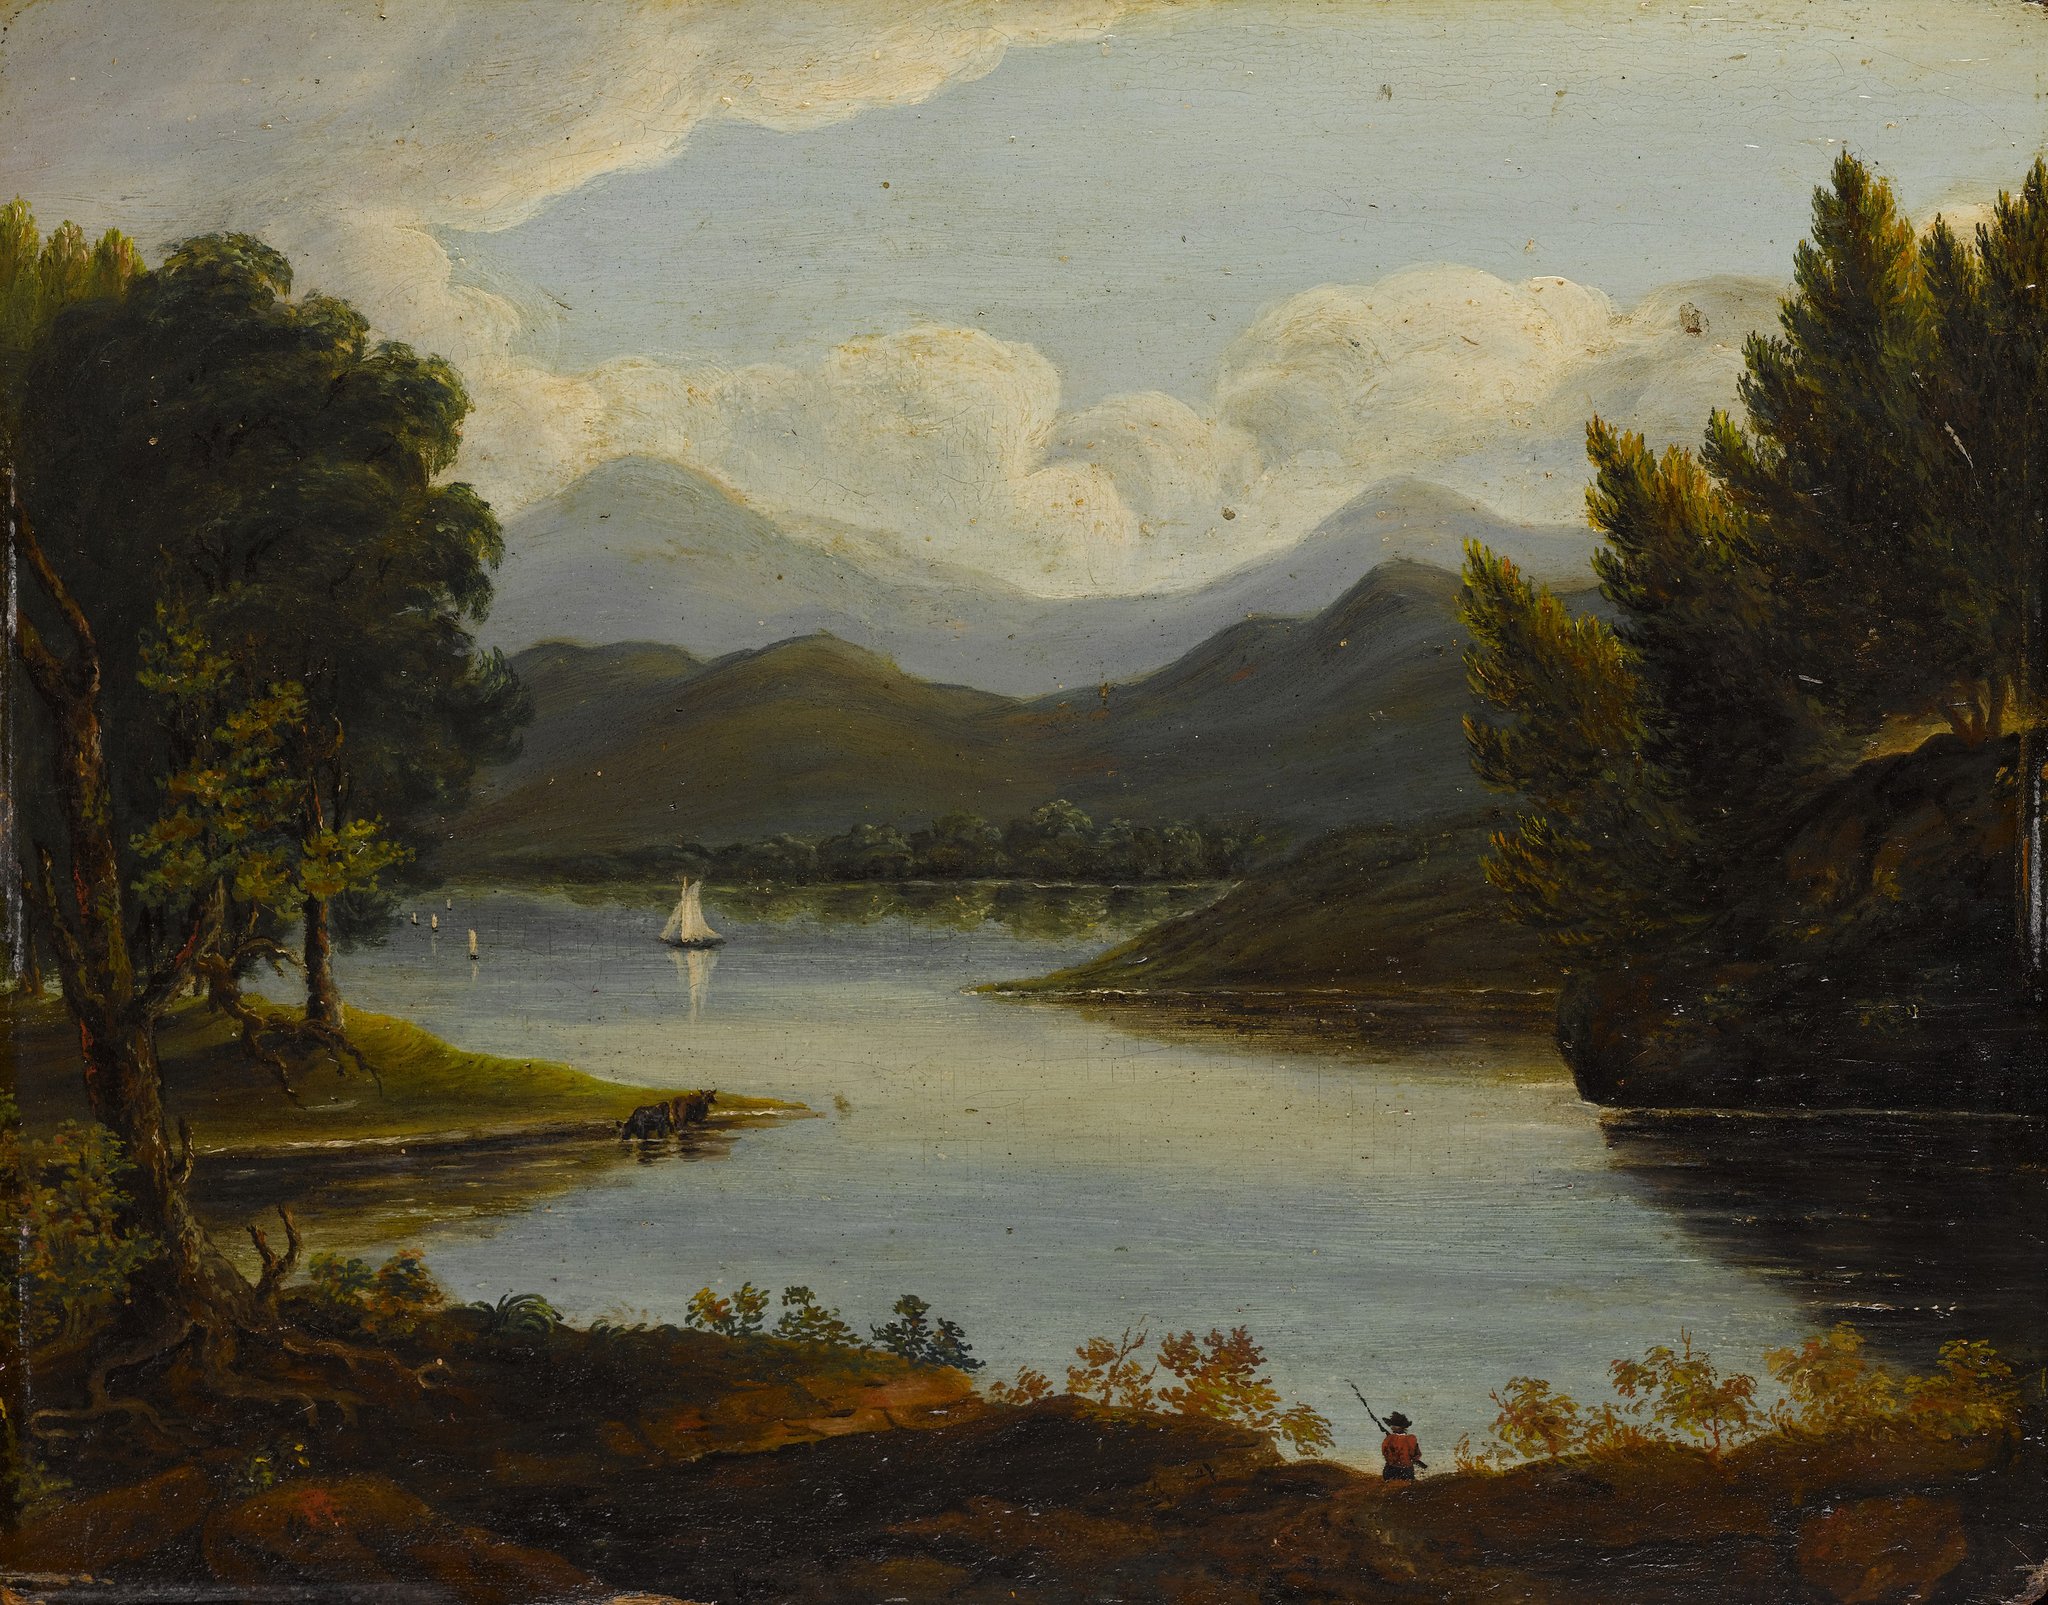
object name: painting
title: Hudson River Scene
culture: american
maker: french or american artist (possibly victor de grailly, paris, 1804–1889)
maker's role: artist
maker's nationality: french or american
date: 1830-1850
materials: oil, wood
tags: rivers,landscapes